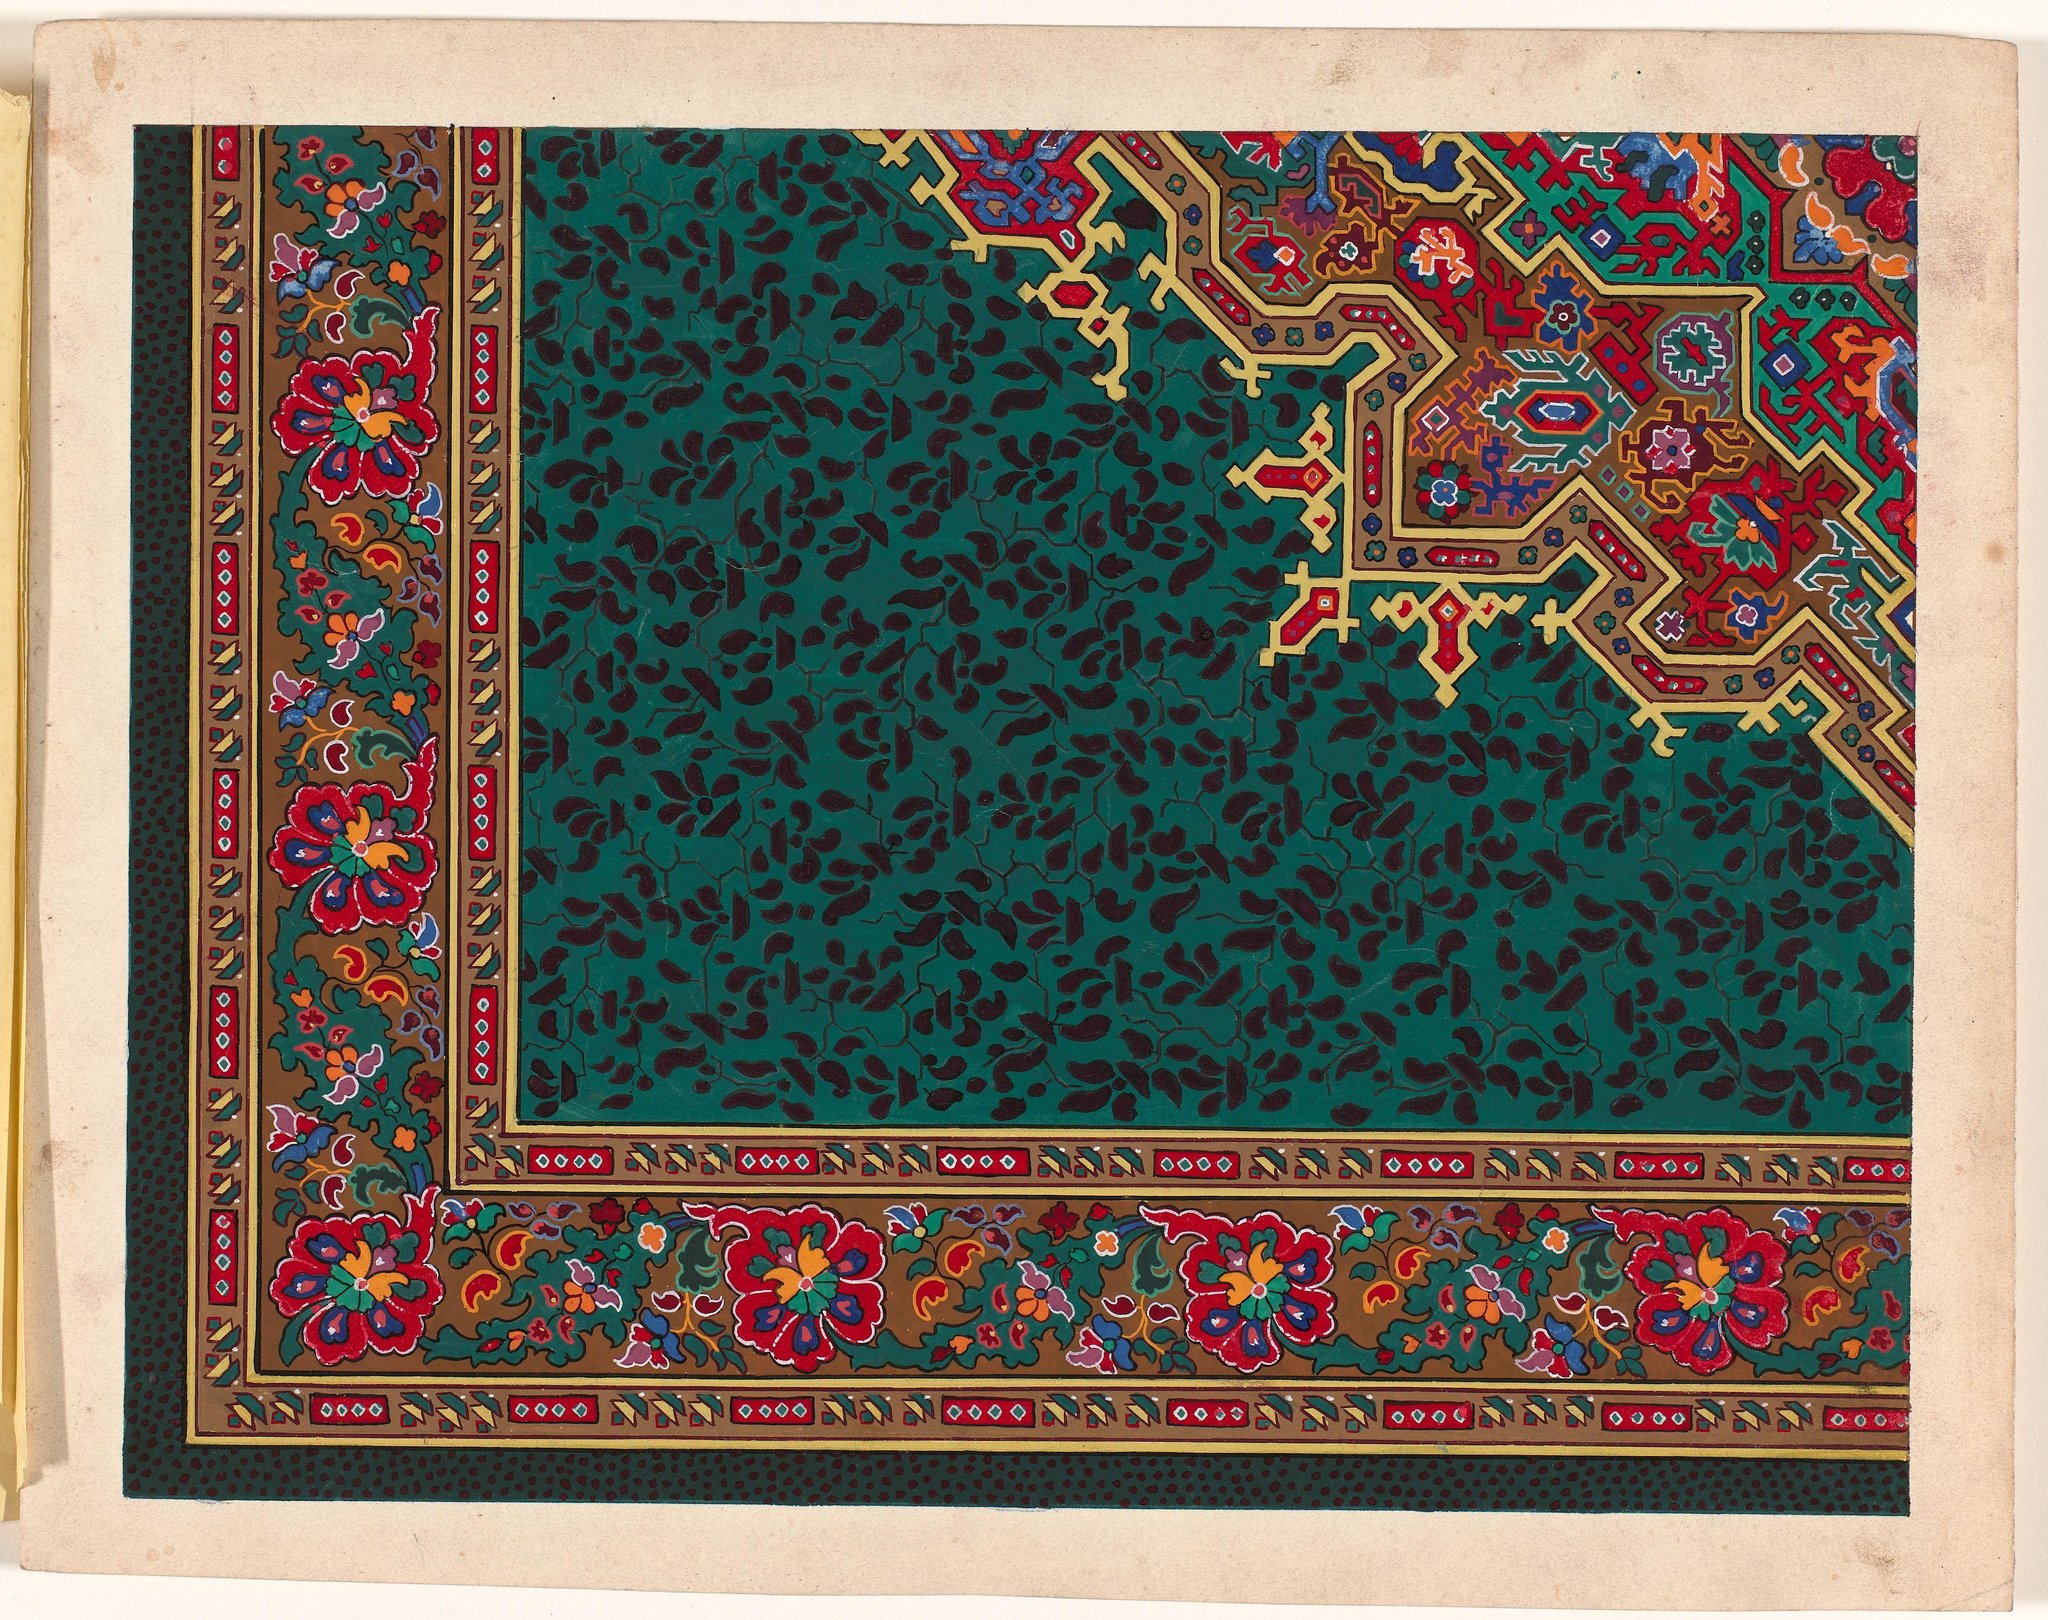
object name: drawing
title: Ontwerp voor een tapijt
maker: Anonymous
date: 1864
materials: gouache, paper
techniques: brush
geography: amsterdam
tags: ornaments ~ art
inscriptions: inscription: ‘Ontvangen per brief 29 Aug 1864.’, number: ‘No 54.ii.’, retailer's mark: ‘JHS.’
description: De presentatietekeningen BK-1971-77-1 t/m 86 zijn kopieën van de originele ontwerptekeningen. Ze werden gemaakt voor vertegenwoordigers van bijvoorbeeld magazijnen, die ze aan hun klanten konden tonen. De meeste tekeningen tonen een kwart van het dessin inclusief rand, middenpartij (de zogenaamde grond of fond) en centraal medaillon. Door het gebruik van spiegels kan de illusie van het gehele tapijt worden opgeroepen. Een deel van de tekeningen heeft een alfabetische opeenvolgende letter als kenmerk, de andere groep een cijfer.Waarschijnlijk is de reeks dessins met een letter eerder samengesteld dan de genummerde tekeningen.